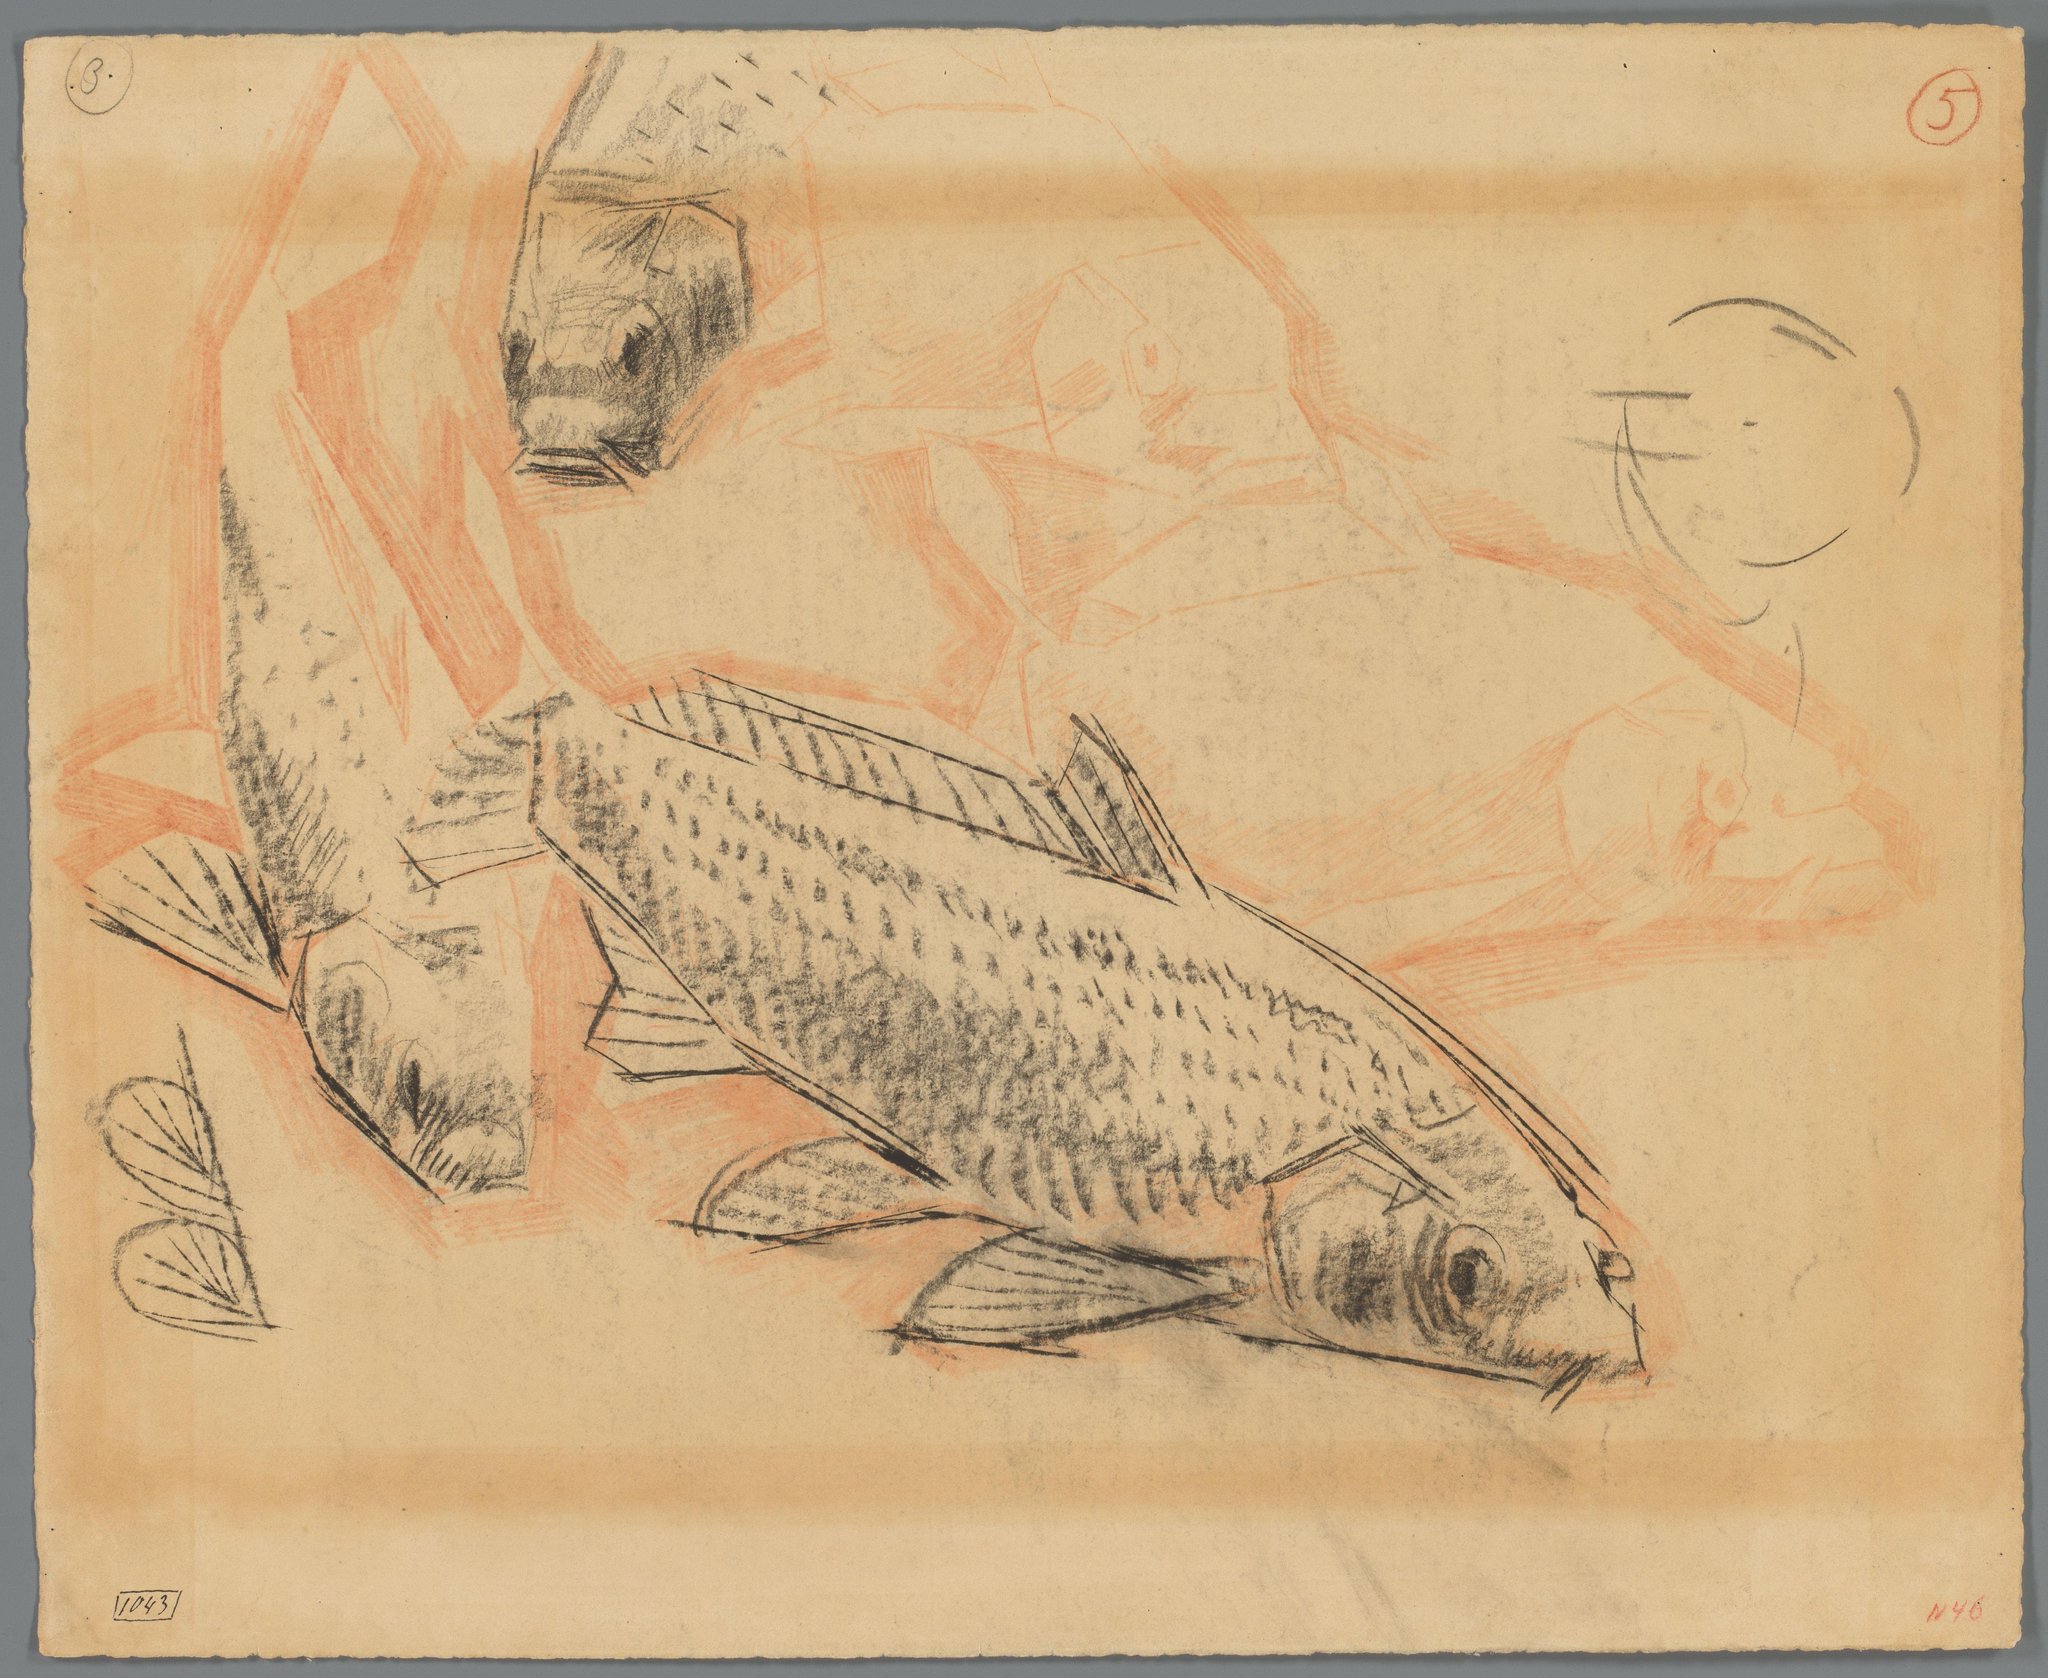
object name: drawing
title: Studies van karpers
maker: gerrit willem dijsselhof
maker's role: designer, draughtsman, print maker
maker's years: 1866-1924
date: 1876-1924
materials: chalk, paper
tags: bony fishes: carp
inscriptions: number: ‘1043’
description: Rechtsboven genummerd: 5. Met een schets op verso.